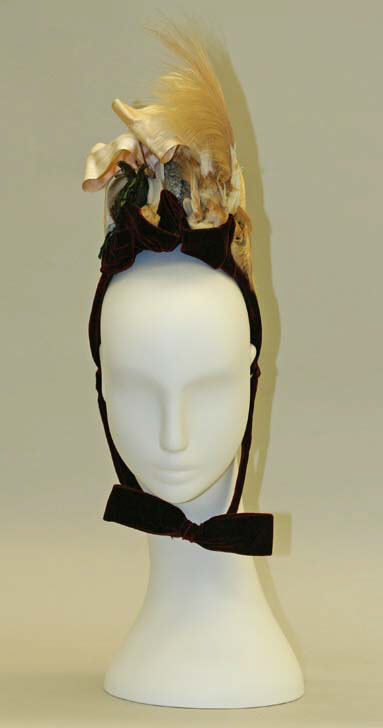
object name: bonnet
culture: american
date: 1886-1889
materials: feather, metal, silk